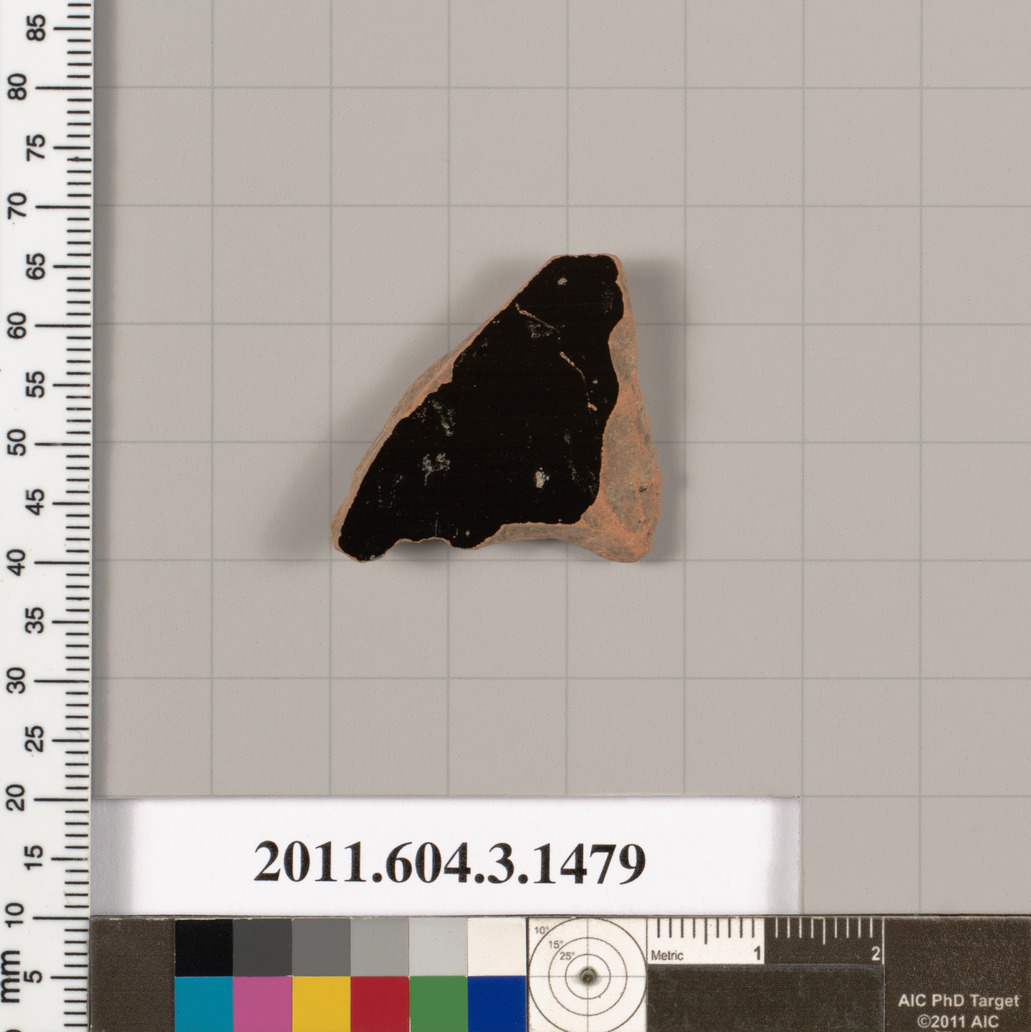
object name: skyphos fragment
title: Terracotta fragment of a skyphos (deep drinking cup)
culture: greek, attic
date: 600-401 BCE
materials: terracotta